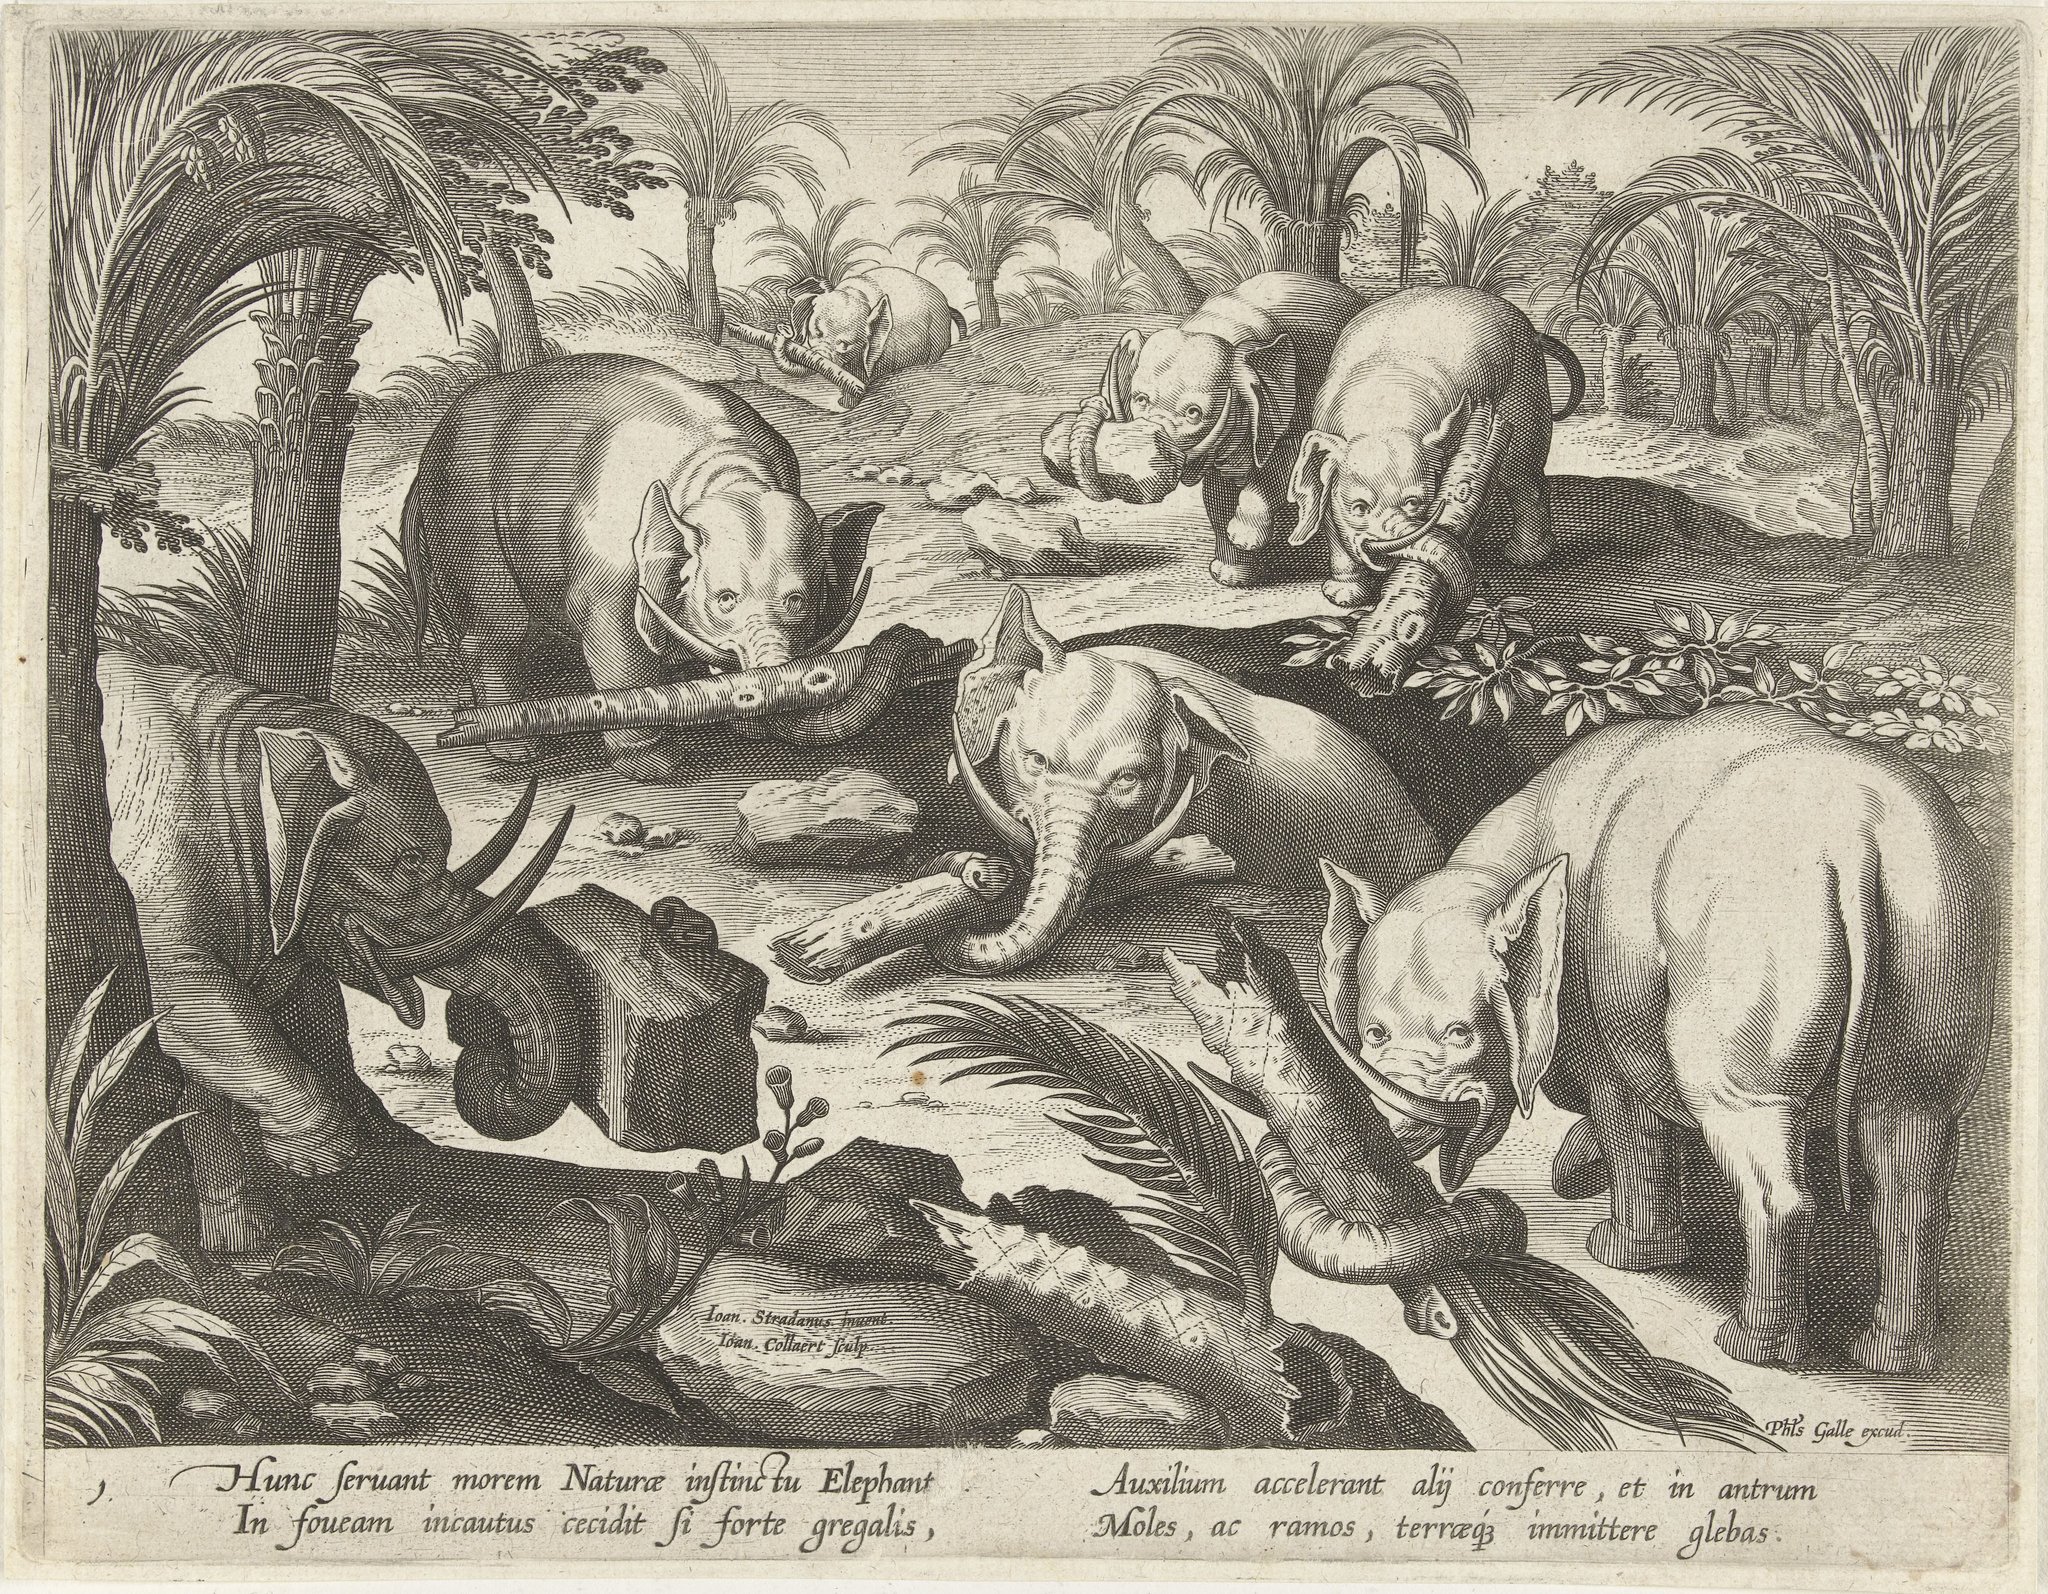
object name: print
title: Olifanten helpen een soortgenoot uit een val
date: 1596-1628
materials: paper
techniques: engraving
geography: florence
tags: transport of timber, timber-trailer, pitfalls, trunked animals: elephant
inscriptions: collector's mark: Lugt 240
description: Een olifant is in een kuil gevallen. Verschillende andere olifanten proberen hem er uit te halen door boomstammen en stenen aan te brengen. De prent heeft een Latijns onderschrift en is deel van een serie over jachttaferelen.